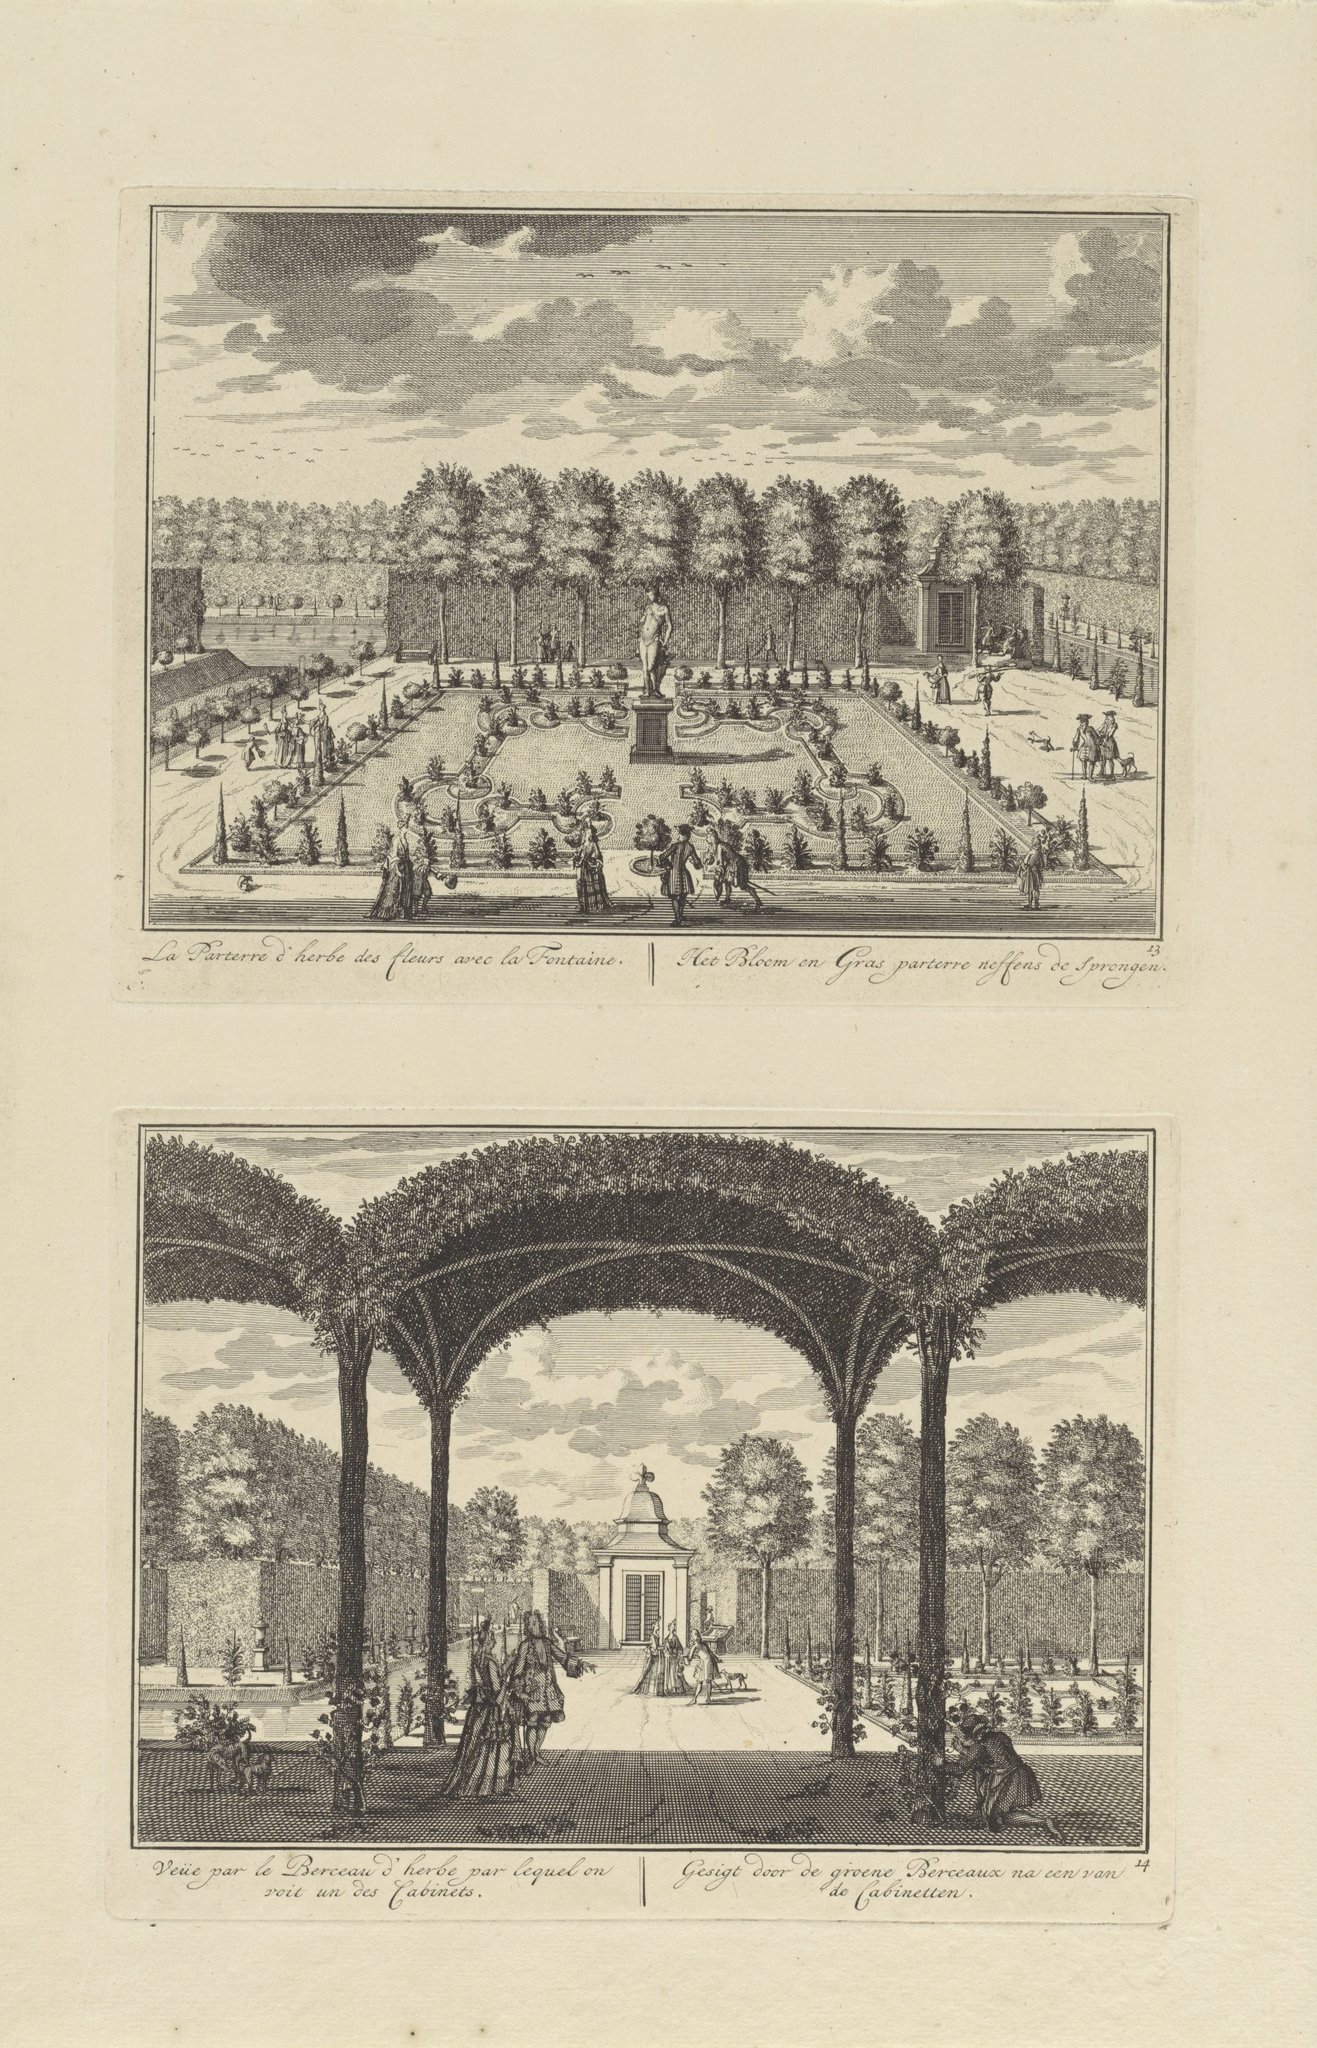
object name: print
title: Gezicht op de tuin aan de zuidzijde van Slot Zeist / Gezicht door de berceau van Slot Zeist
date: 1682-1726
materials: paper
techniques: etching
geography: amsterdam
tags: french or architectonic garden; formal garden, statues, sculptures in garden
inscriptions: collector's mark: Lugt 2228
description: Twee voorstellingen op een blad. Boven: Gezicht op de parterre met gras en banden met bloeiende planten aan de zuidzijde van Slot Zeist, met links de fonteintjes, uit het noordwesten. Onder: Gezicht door de loofgang rond de tuin achter Slot Zeist, op het noordwestelijke tuinpaviljoen, uit het zuidoosten.